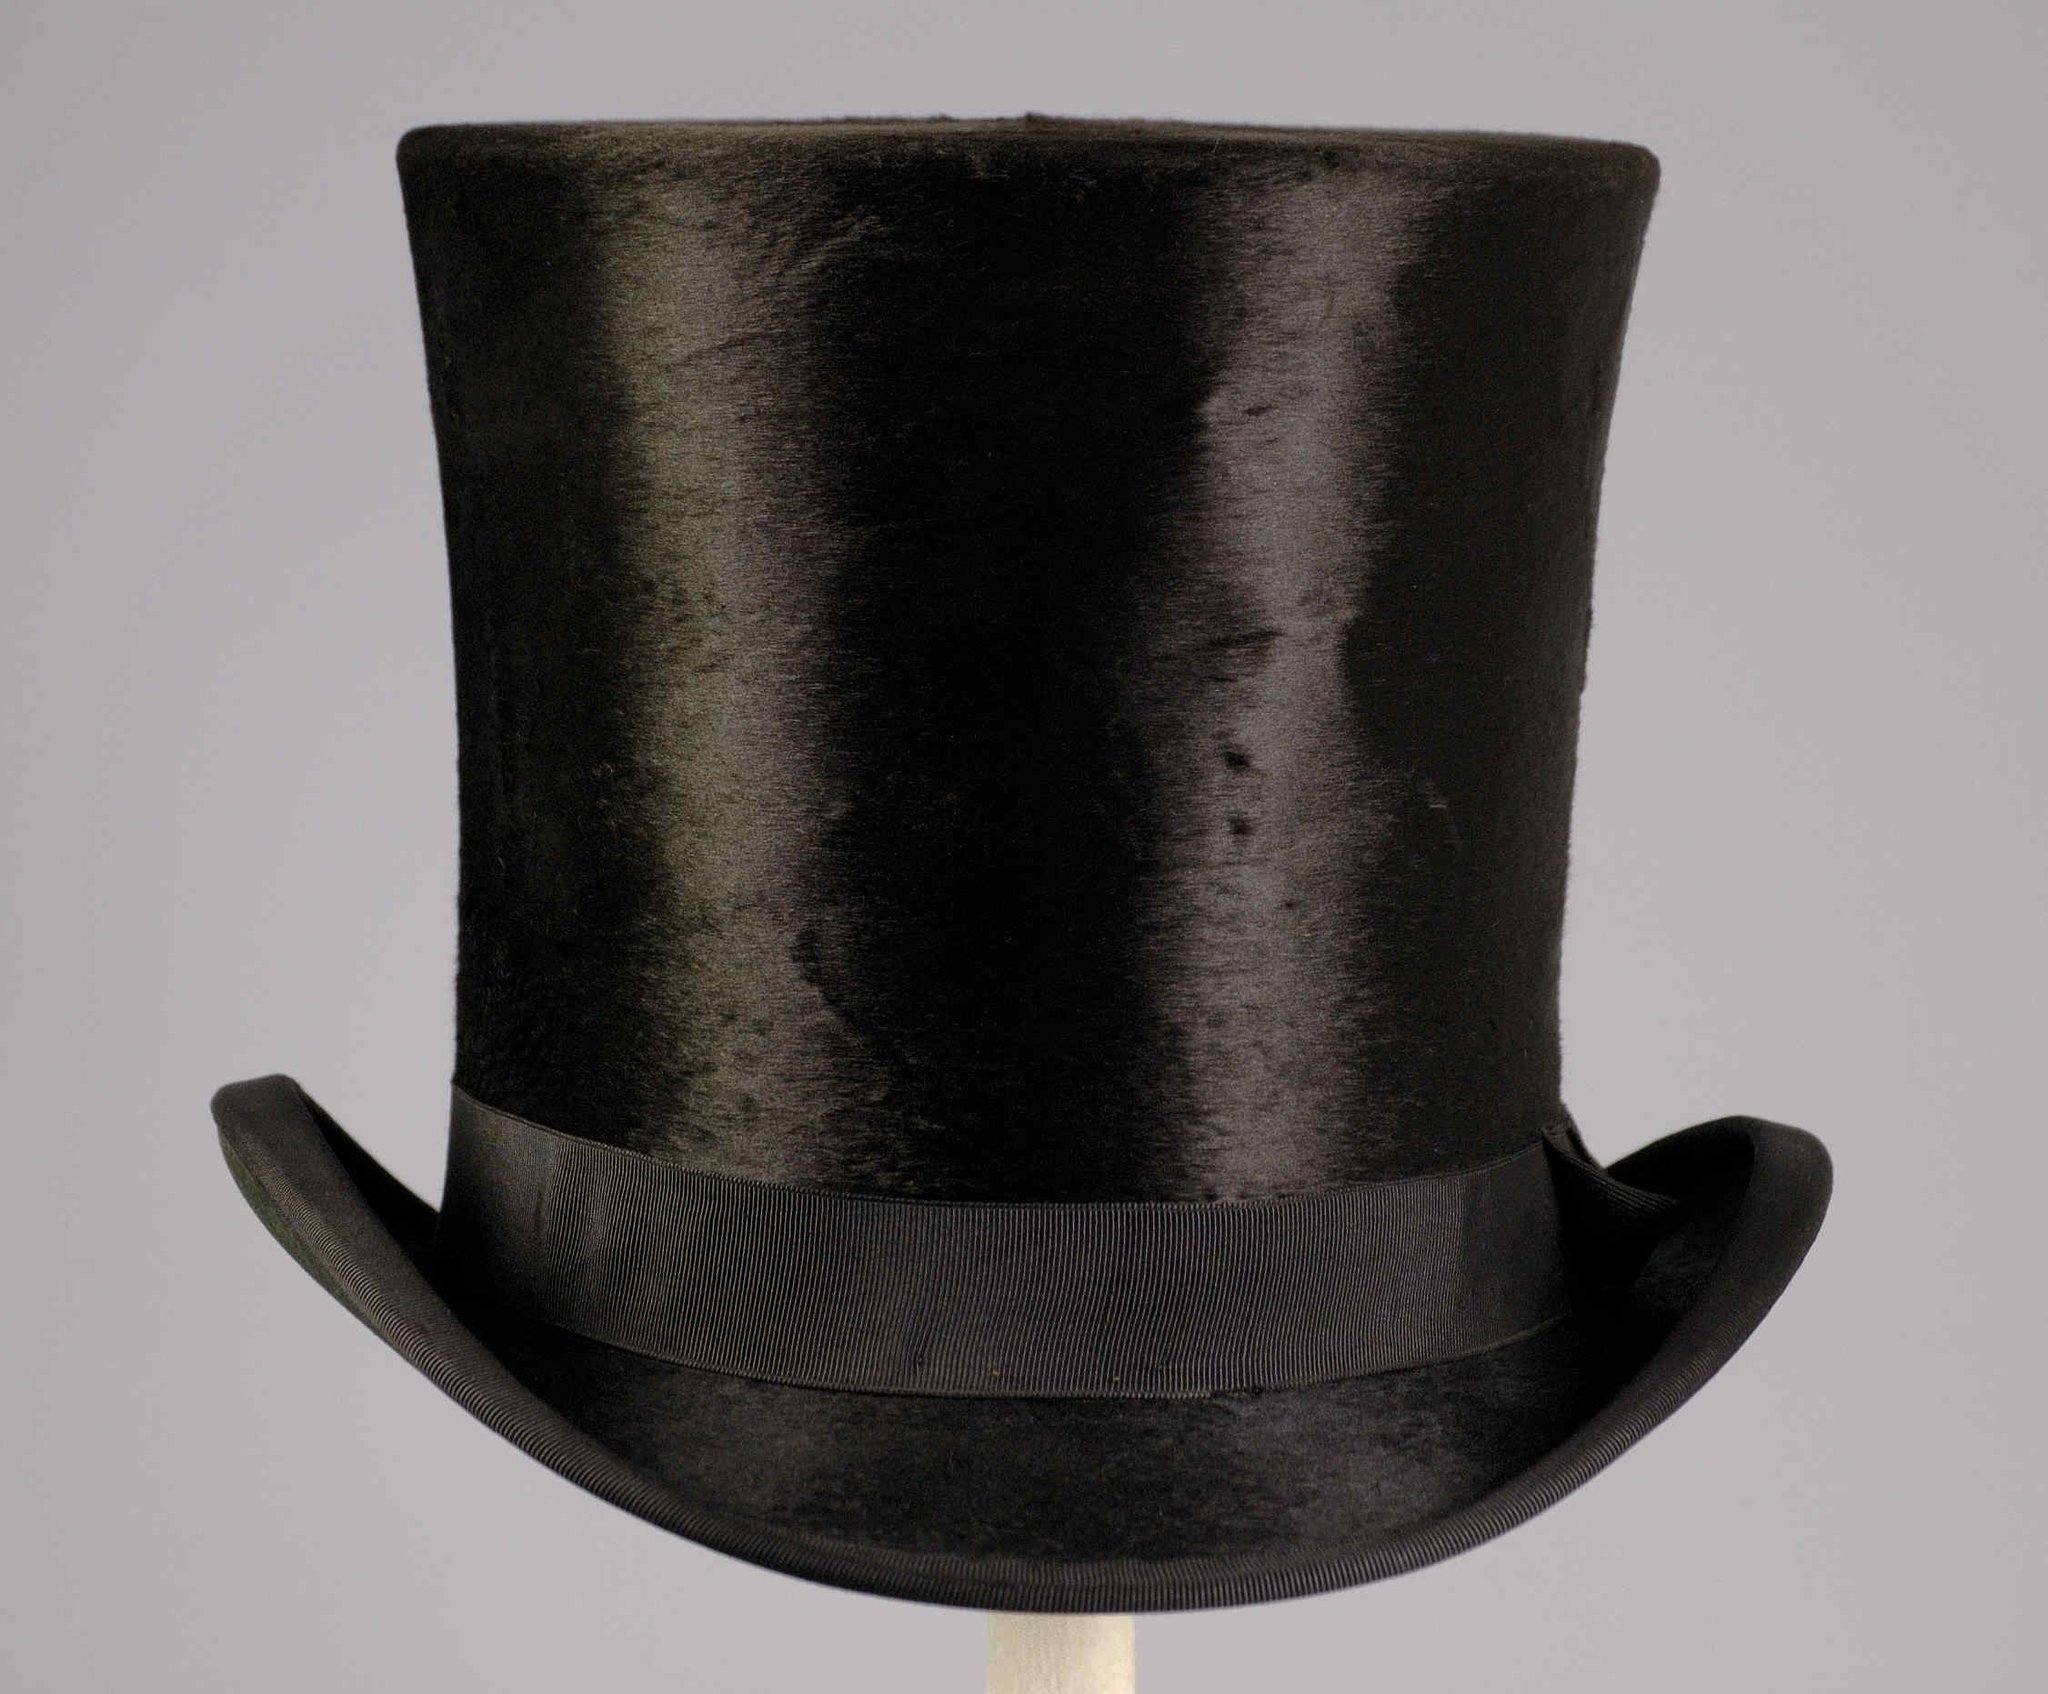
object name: evening hat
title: Evening top hat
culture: american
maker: a. n. cook & company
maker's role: maker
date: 1890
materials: fur, silk